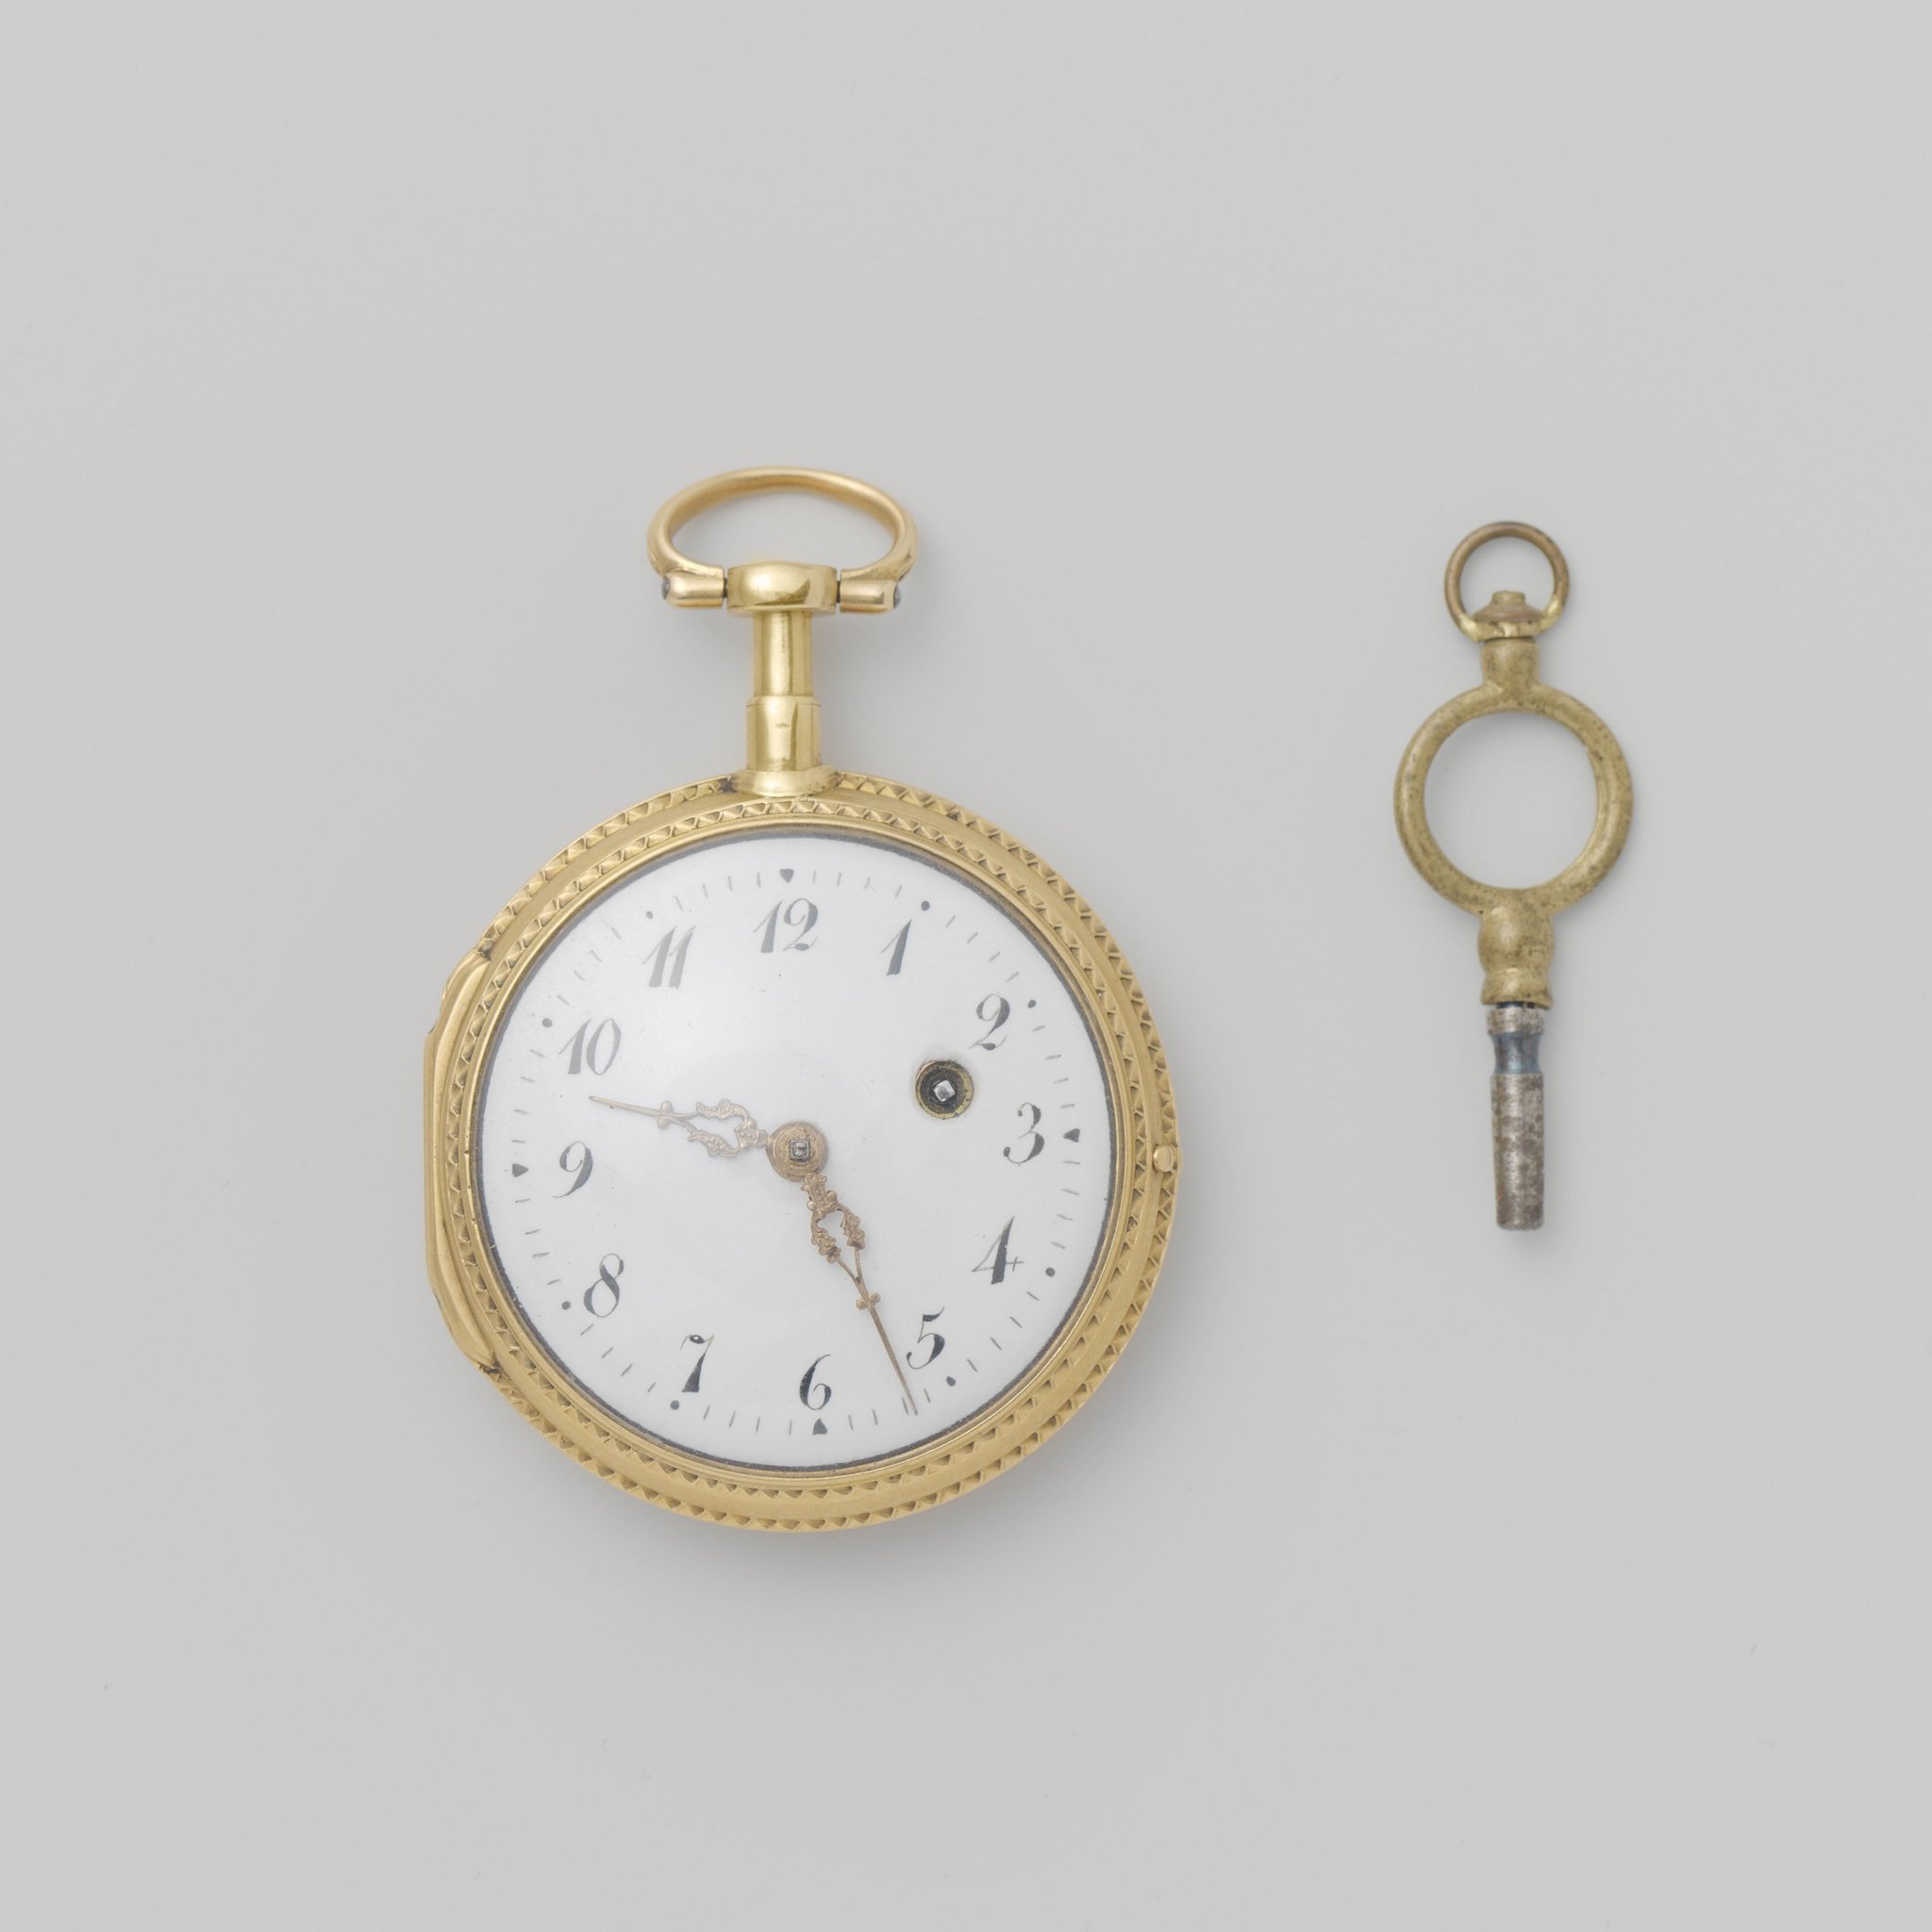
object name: jewellery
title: Horloge van goud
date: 1780-1781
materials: gold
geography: paris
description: Gouden horloge met een geëmailleerde wijzerplaat. De achterbodem is glad. Met sleutel.